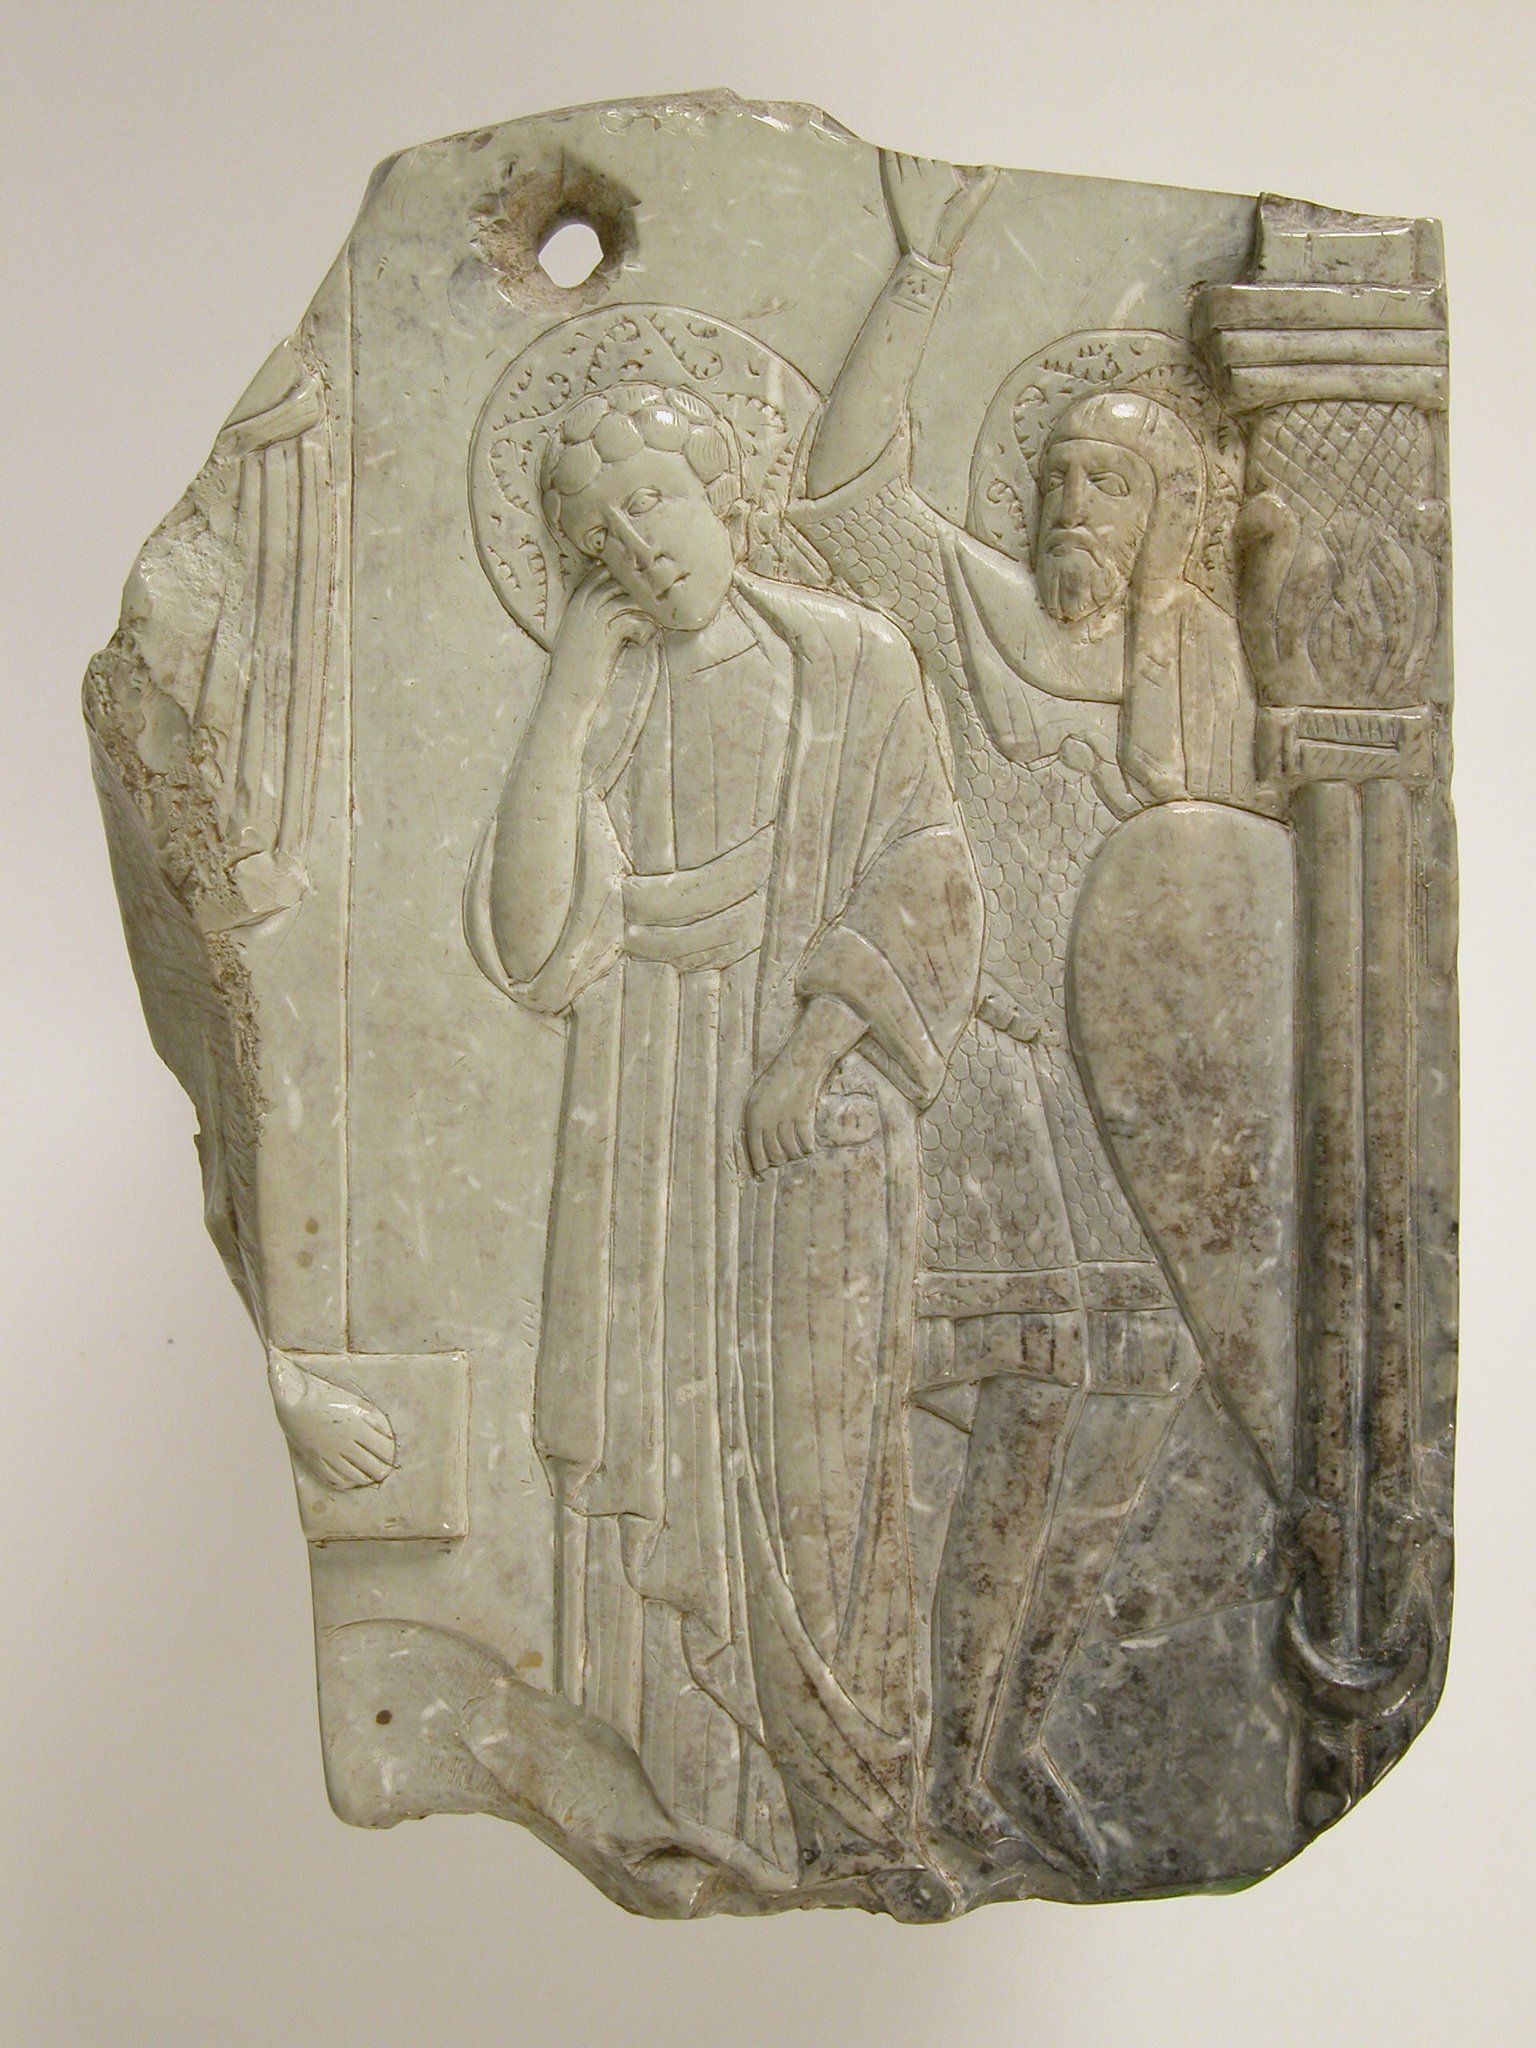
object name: icon fragment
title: Fragment of an Icon with the Crucifixion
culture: byzantine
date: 1101-1200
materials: stone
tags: soldiers,saint john the evangelist